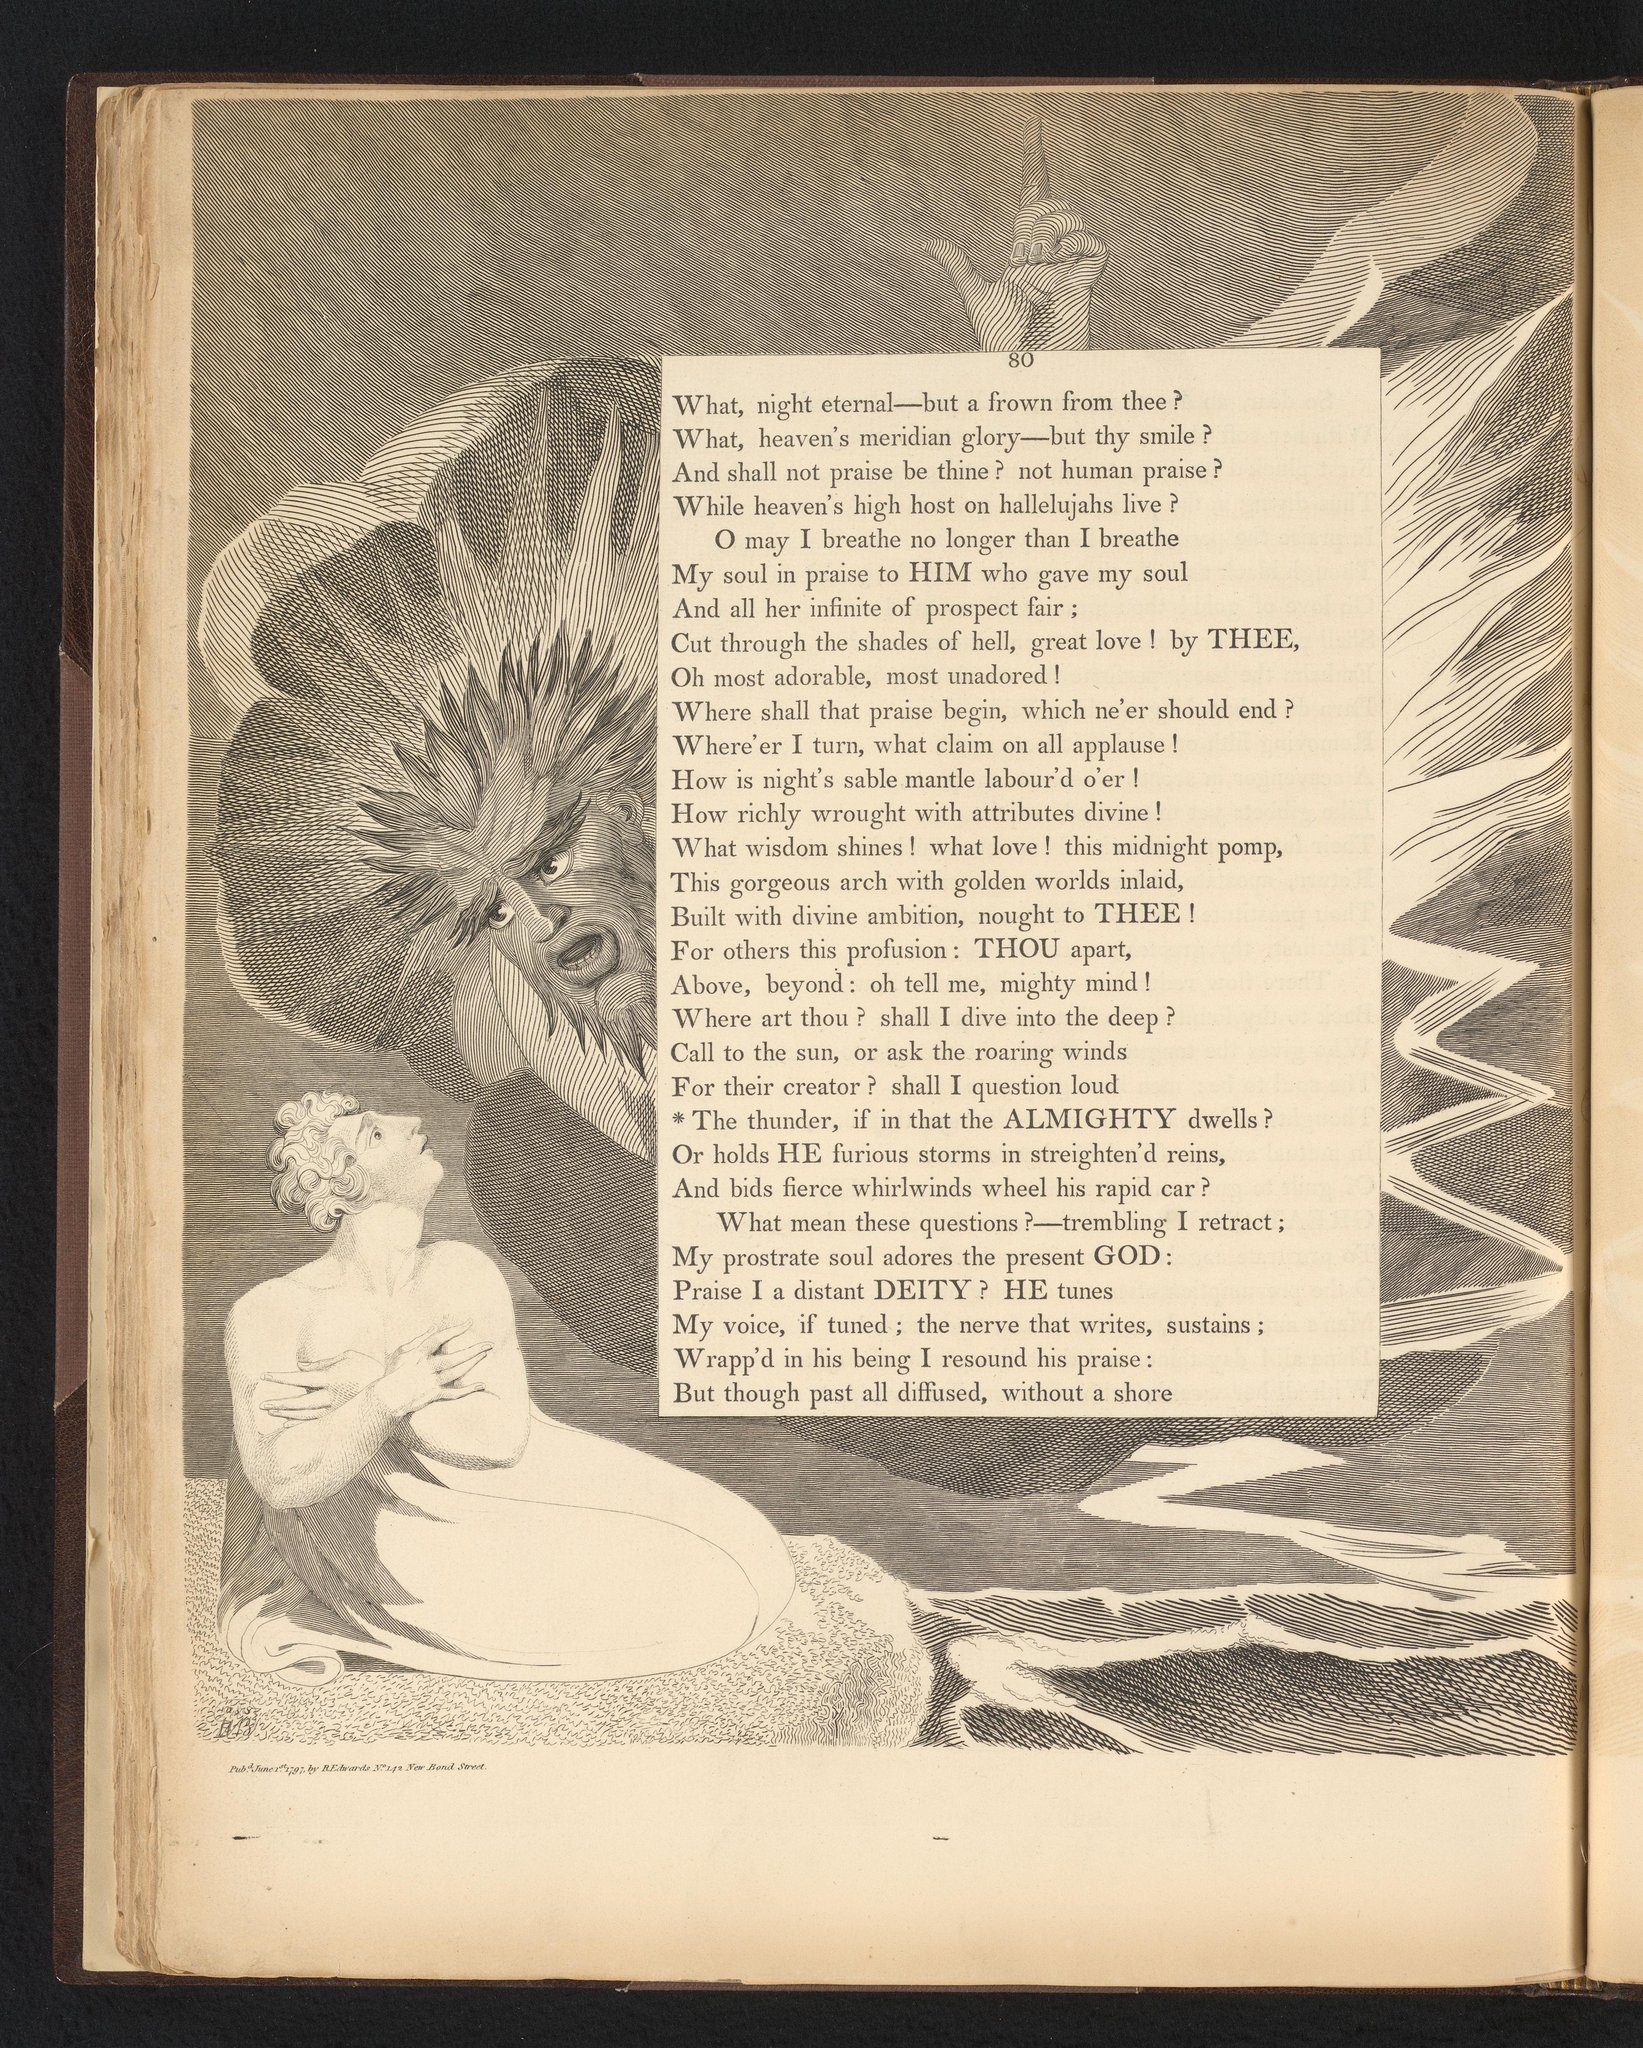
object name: page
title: Man aangesproken door een man vanuit de hemel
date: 1796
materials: paper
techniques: engraving, etching, letterpress printing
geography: london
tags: adult man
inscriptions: : ‘What, night eternal-but a frown from thee ?(...)’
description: Prent maakt deel uit van een boek, bladzijde 80. Tekst in het Engels op het recto en verso.